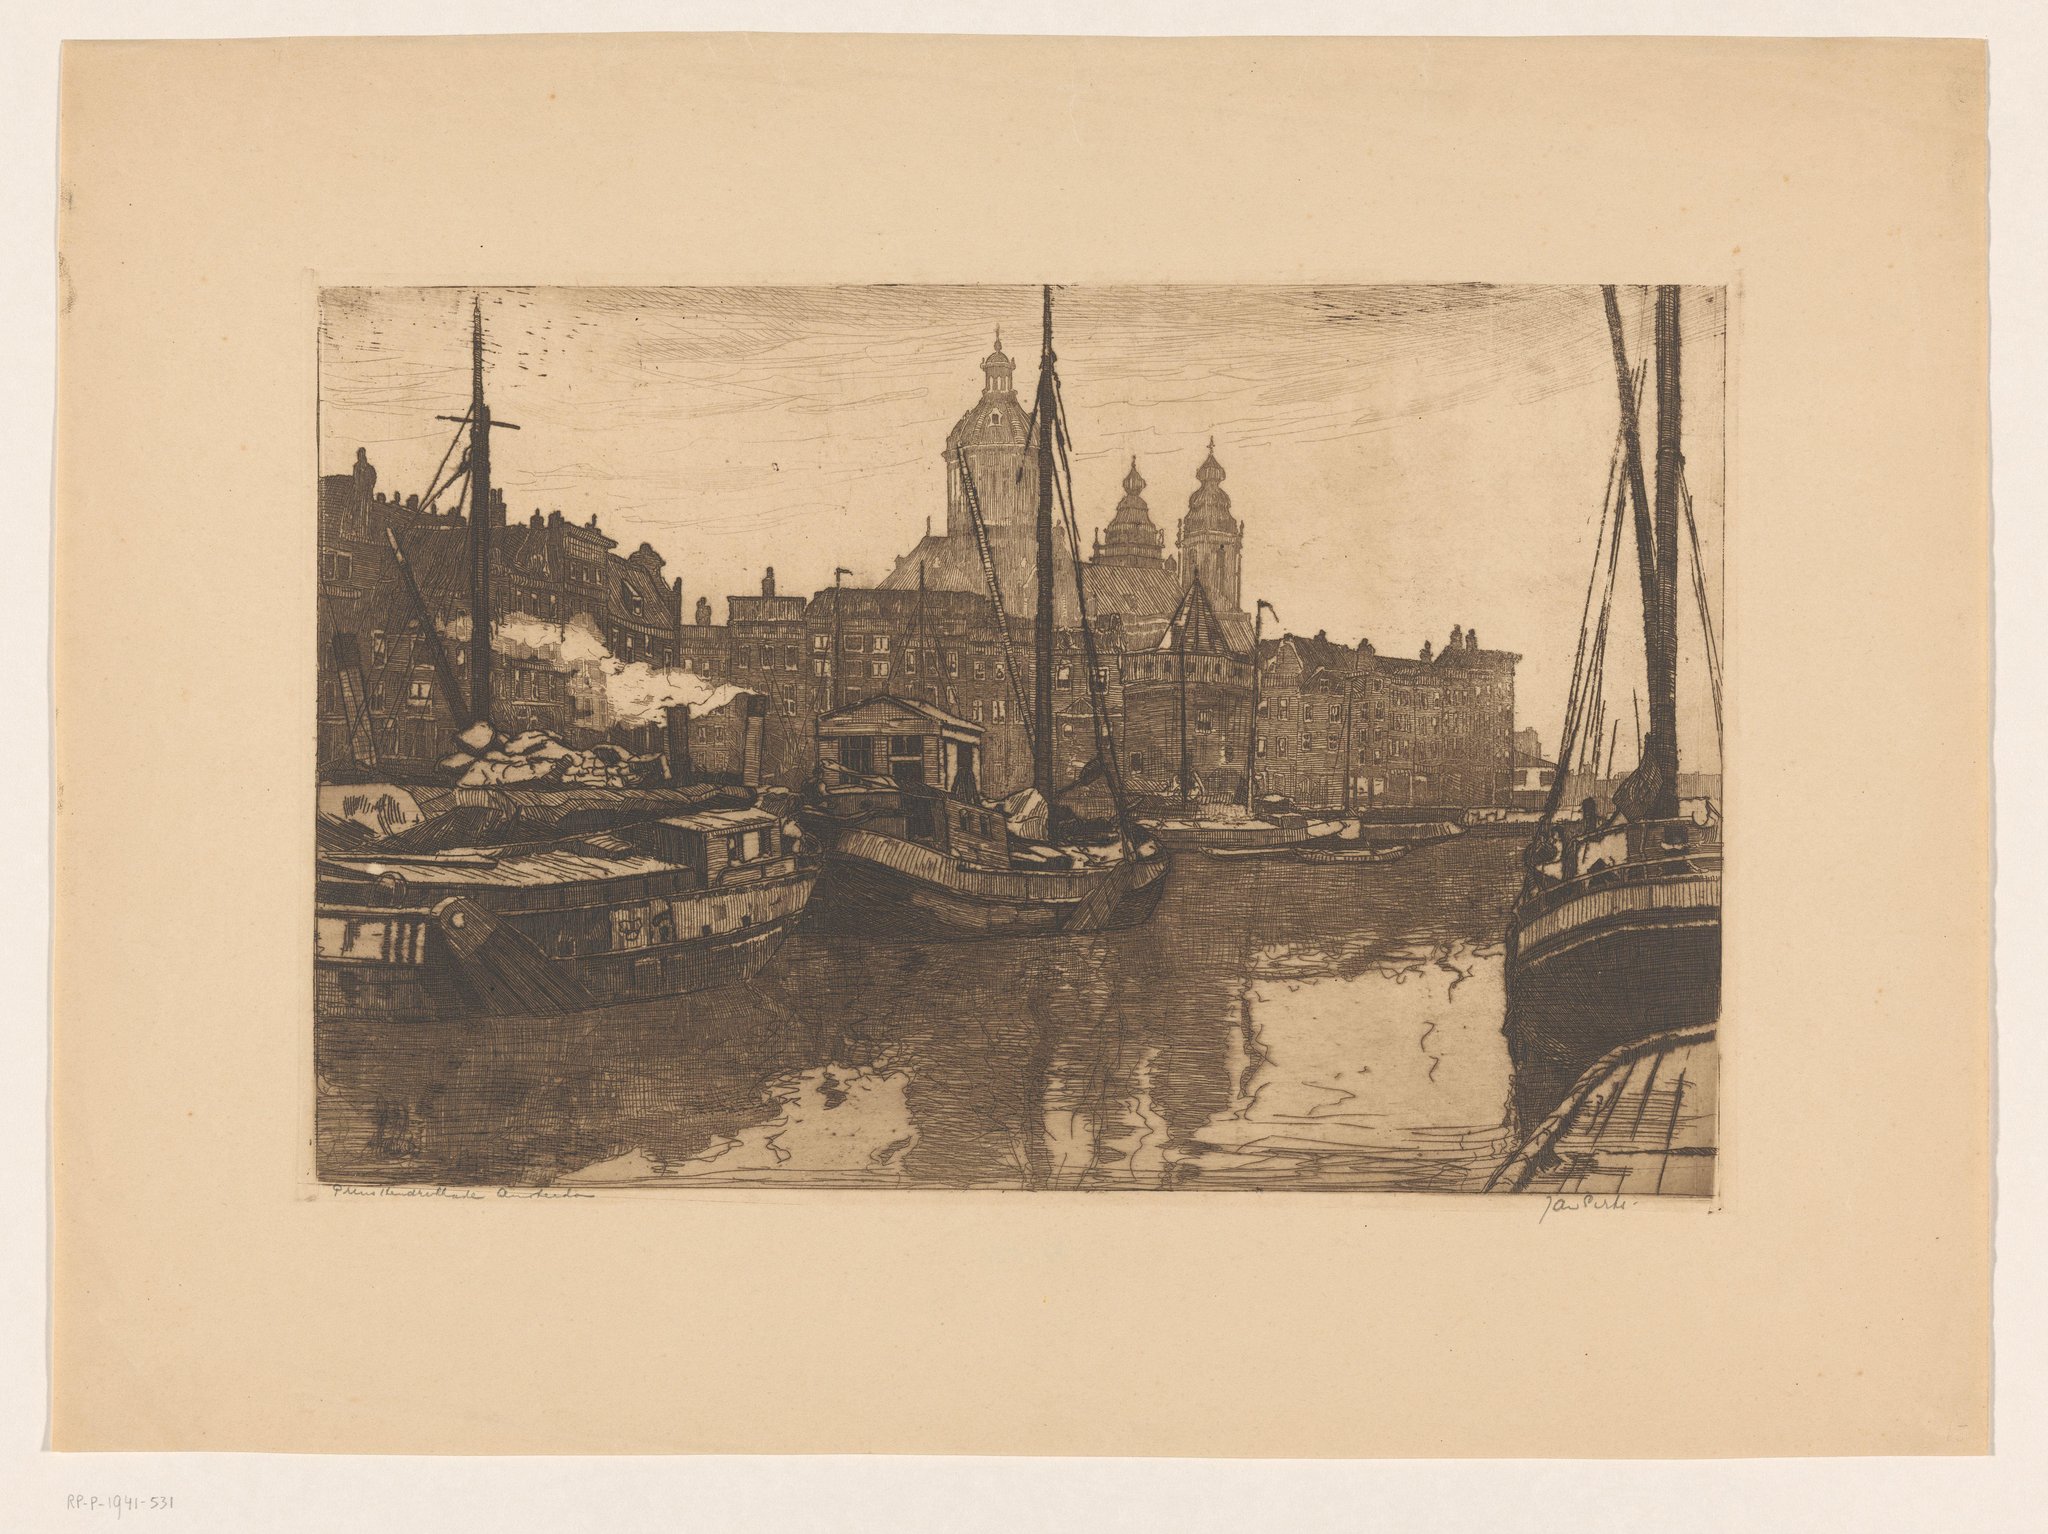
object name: print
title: Gezicht op de Prins Hendrikkade in Amsterdam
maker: jan sirks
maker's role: print maker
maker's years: 1885-1938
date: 1895-1938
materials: paper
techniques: etching, intaglio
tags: canals, waters (in city), parts of church exterior and annexes: tower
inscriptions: collector's mark: Lugt 2760, collector's mark: Lugt 2228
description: Op de voorgrond liggen boten in het water. Op de achtergrond de torens van de Sint-Nicolaaskerk.